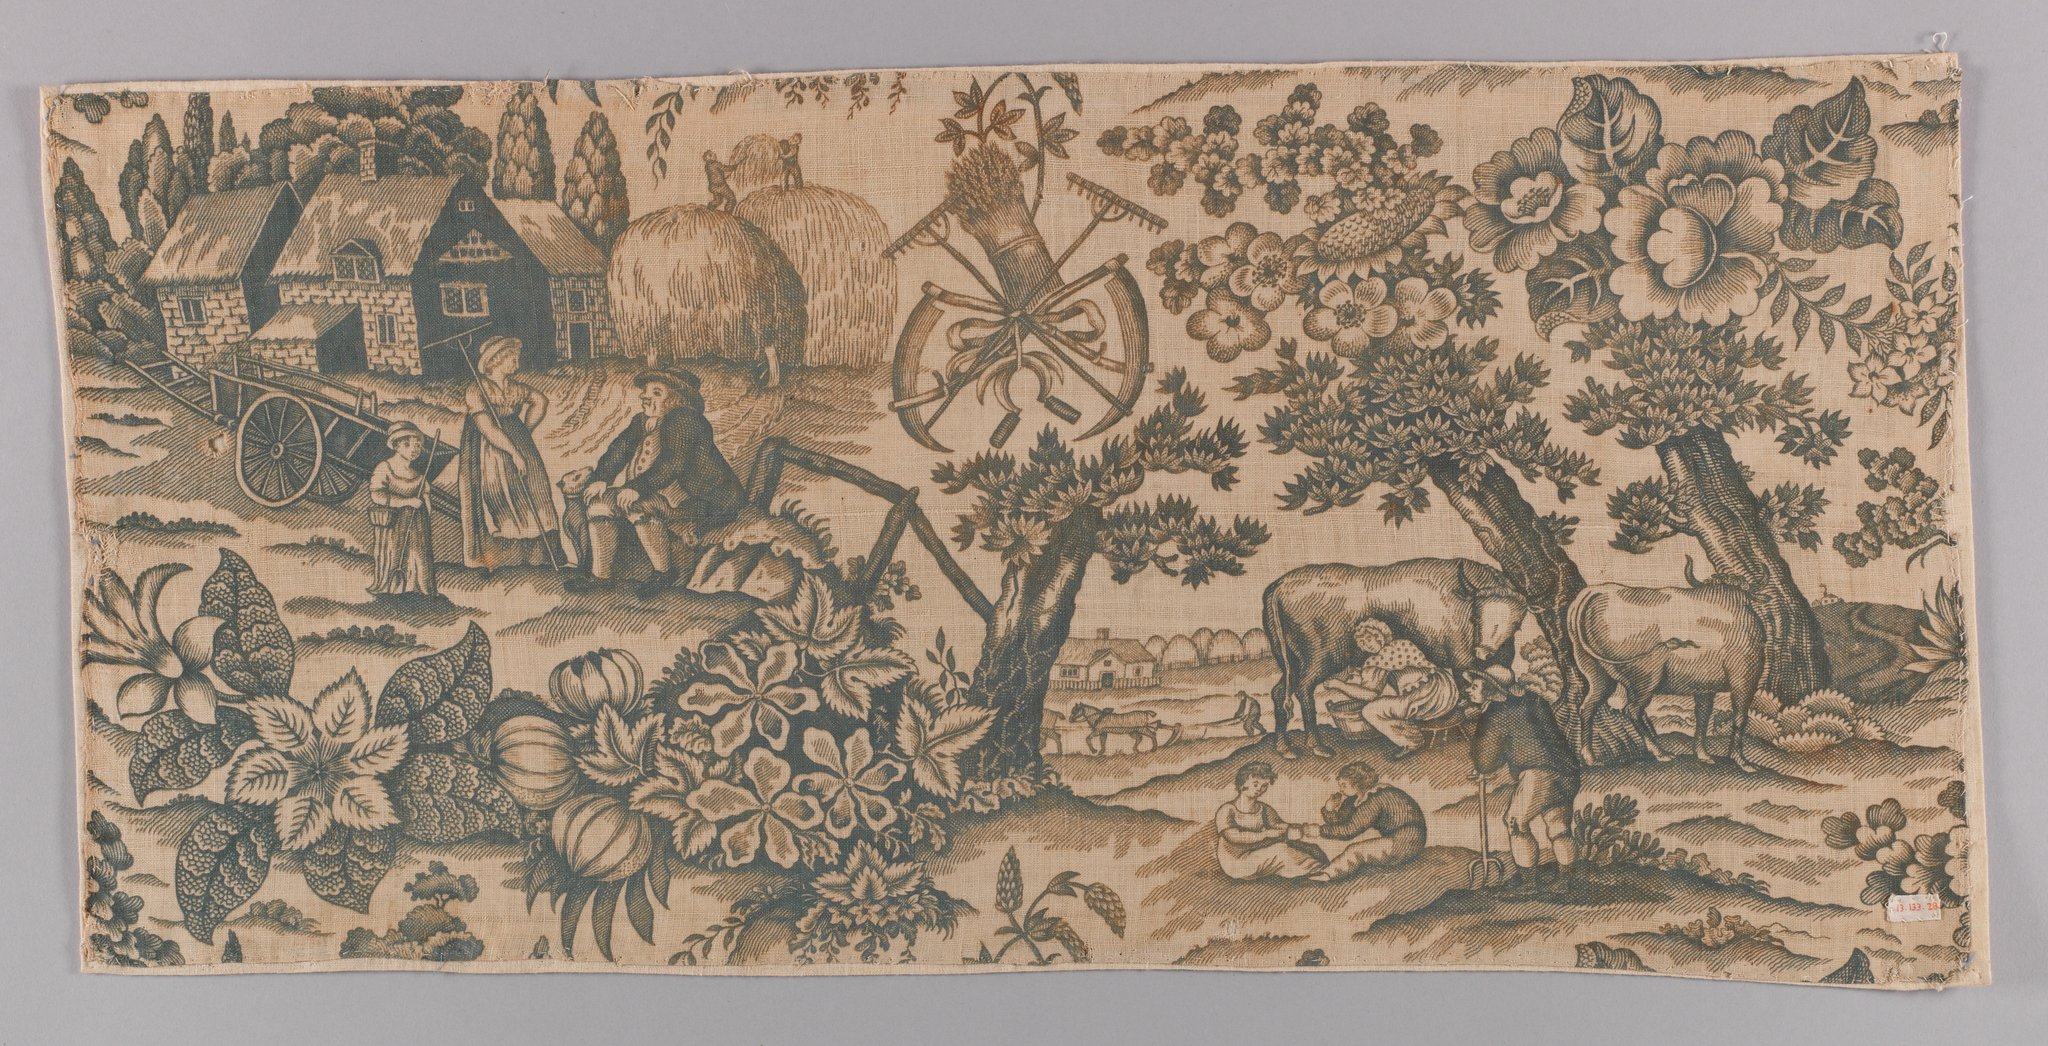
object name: piece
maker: john slack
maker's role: engraver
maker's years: 1775-1875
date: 1825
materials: cotton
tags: houses,men,women,cows